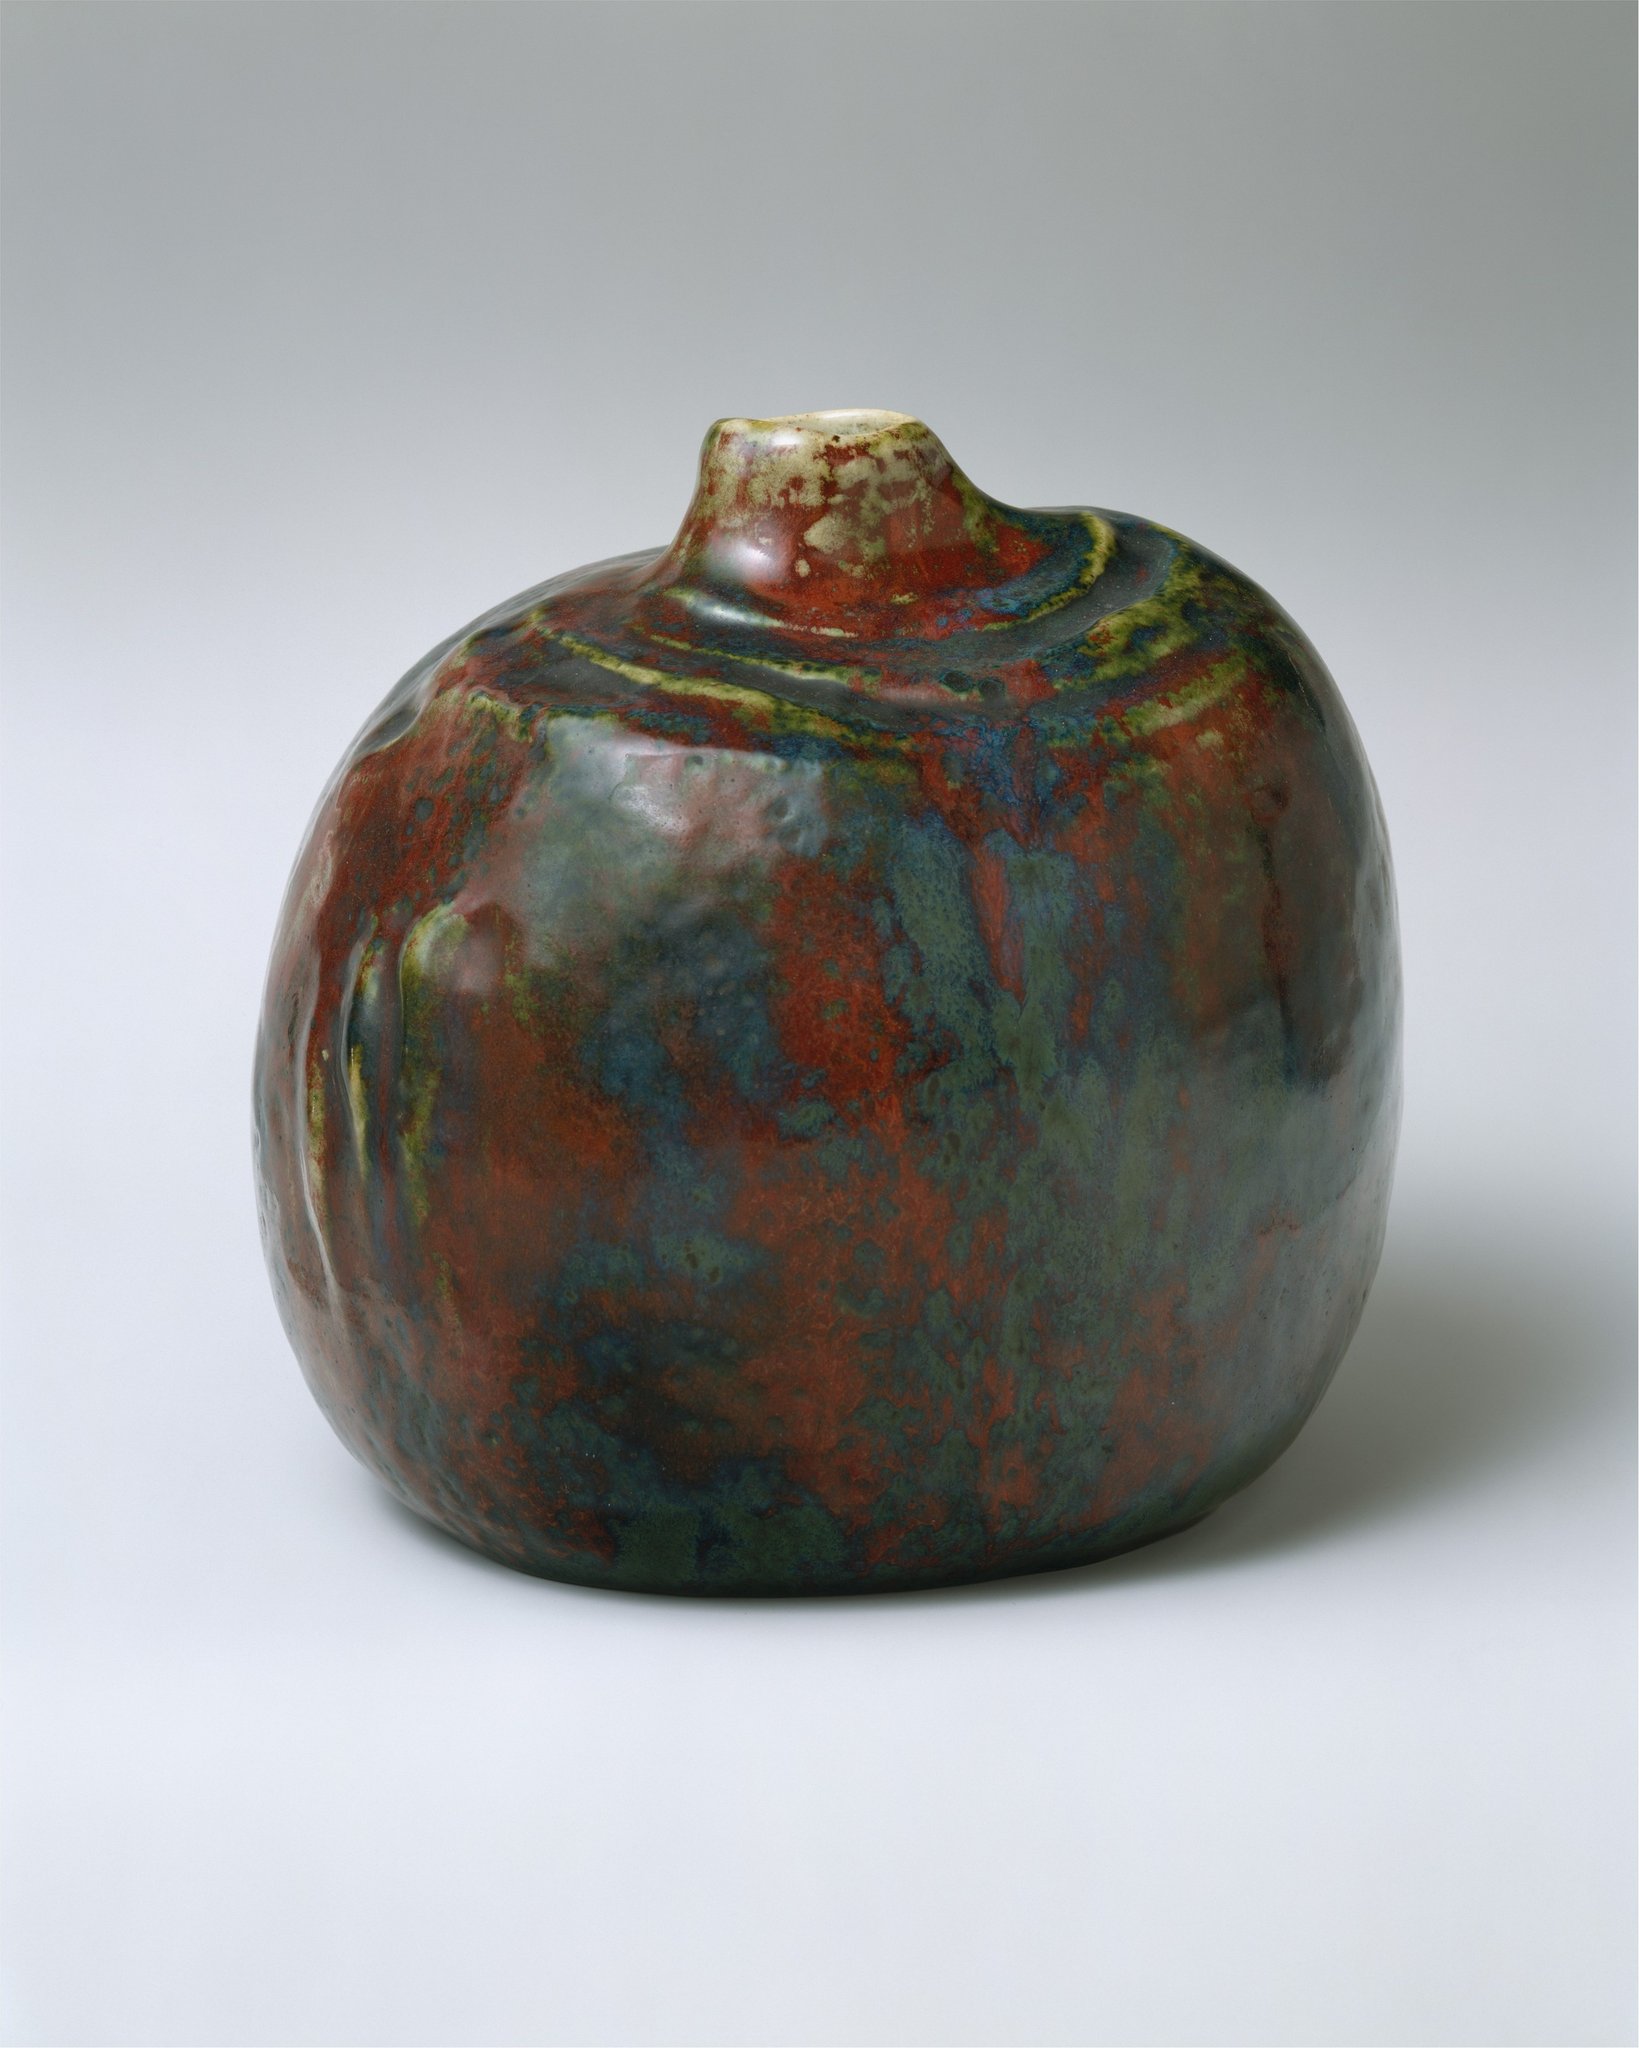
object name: vase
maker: pierre-adrien dalpayrat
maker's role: designer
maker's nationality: french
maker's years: 1844-1910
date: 1897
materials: stoneware